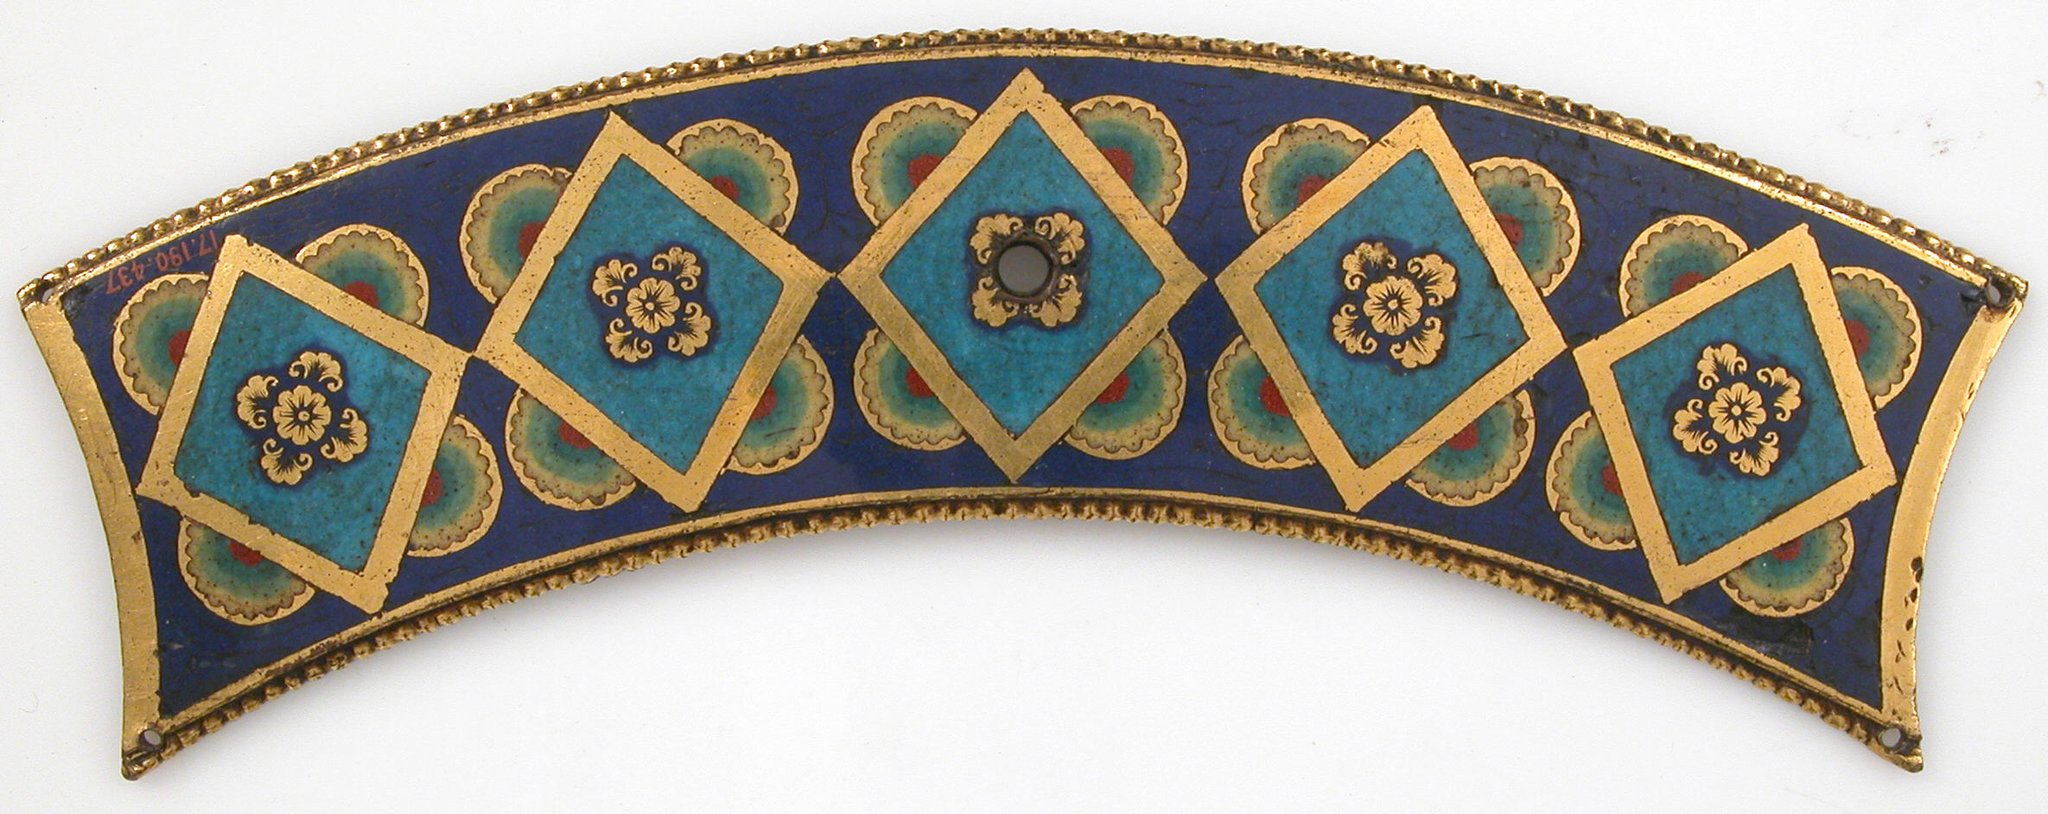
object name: plaque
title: Plaque from a Reliquary Shrine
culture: german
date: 1150-1200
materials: copper alloy, enamel, gilt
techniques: enamel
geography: germany